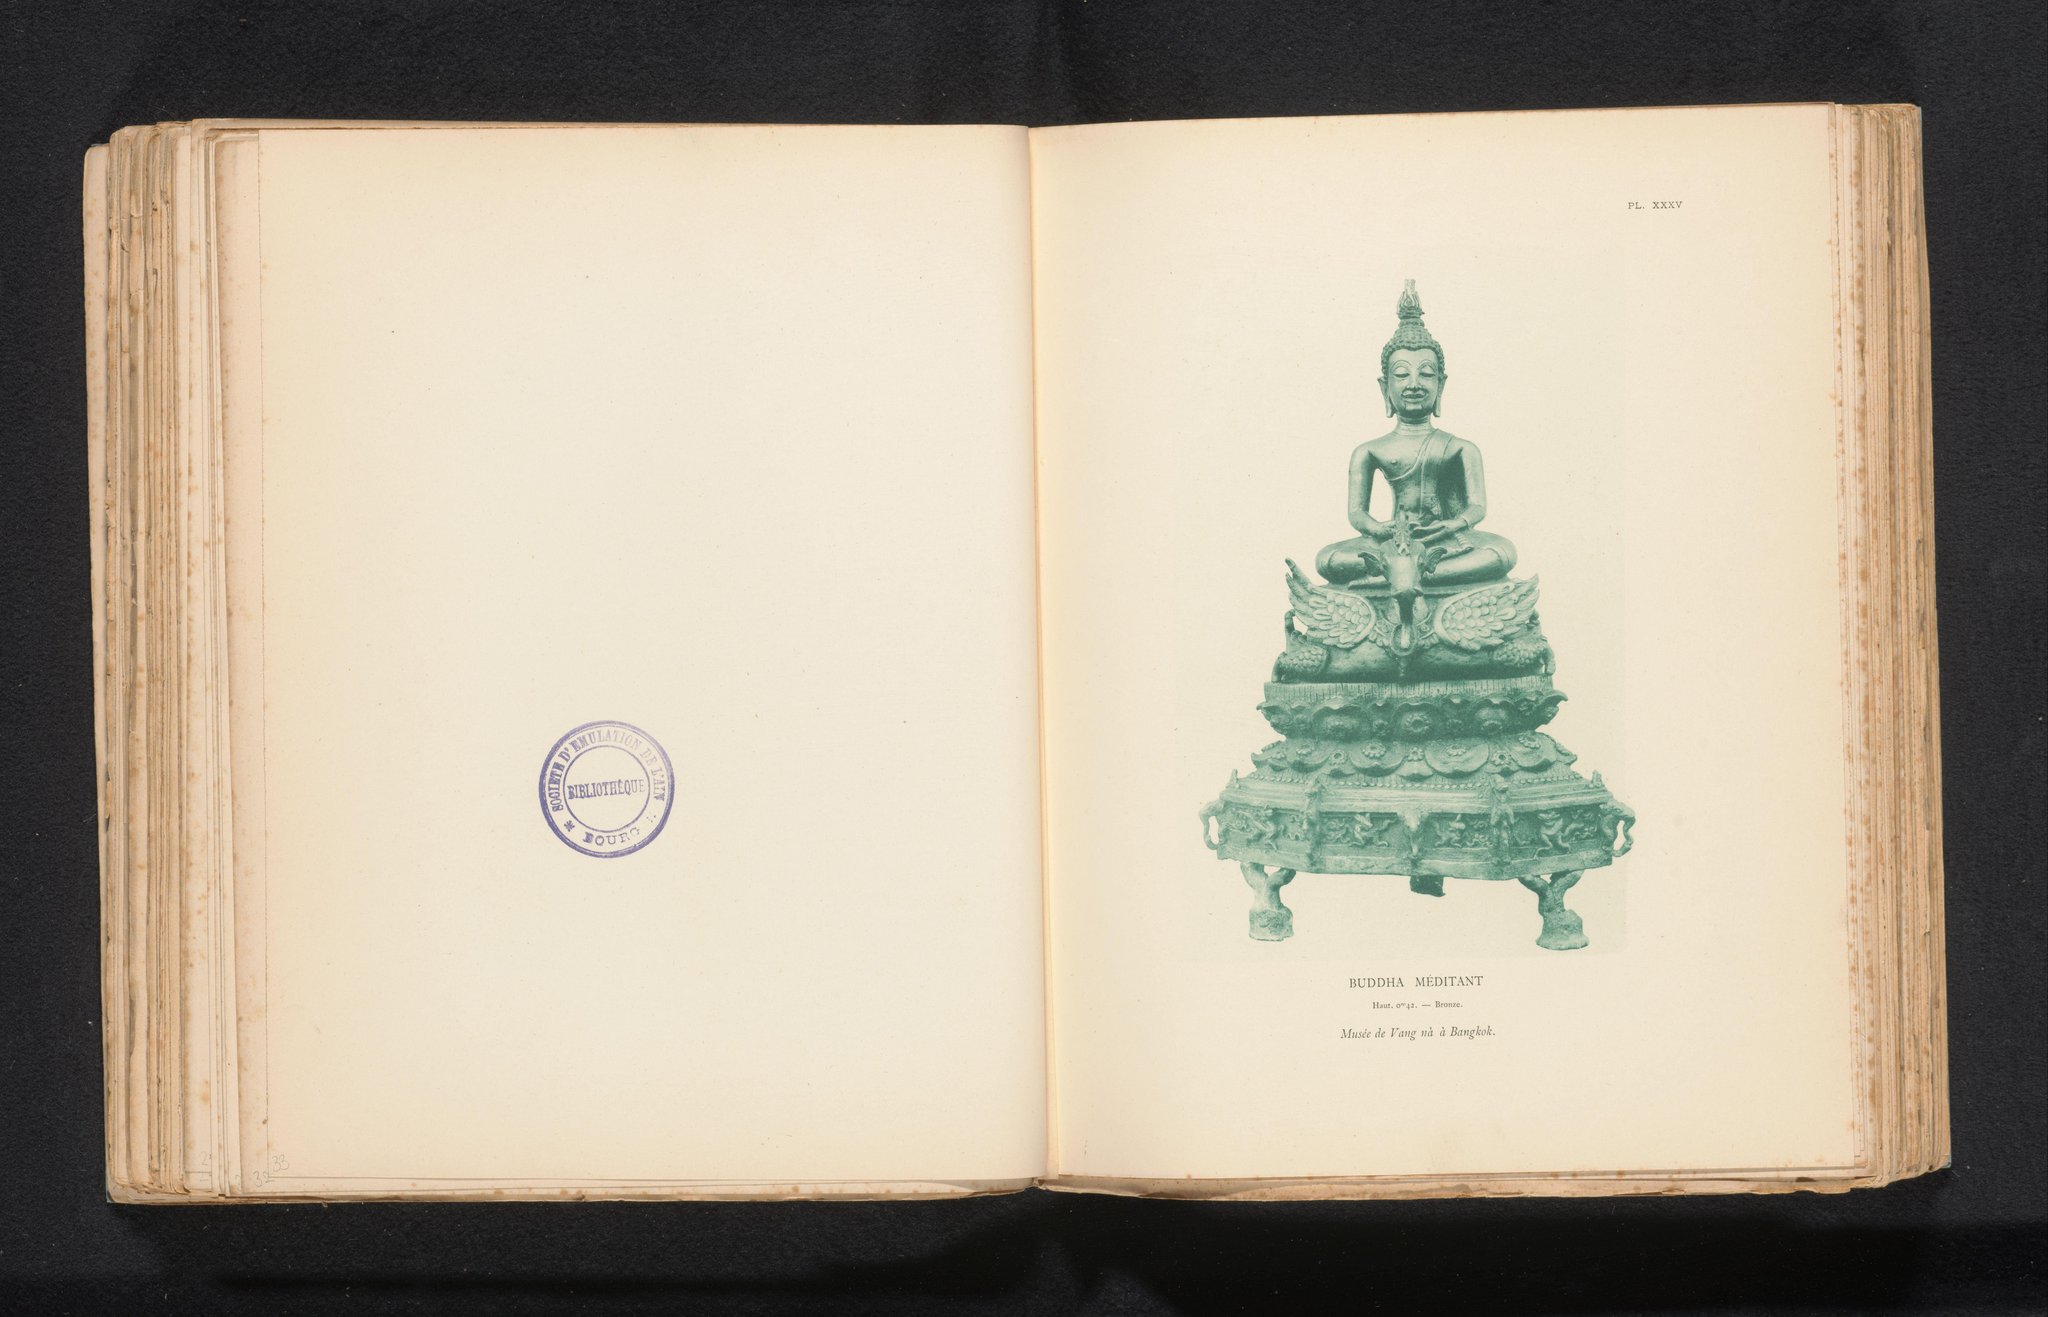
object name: page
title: Sculptuur van Boeddha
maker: Anonymous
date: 1890-1895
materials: paper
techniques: photograph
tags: representations ~ gods, demi-gods, heroes, etc. (hinduism, buddhism, jainism)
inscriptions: collector's mark: ‘Société d'Emulation de l'Ain/ Bourg/ Bibliothèque’, inscription: ‘Pl. XXXV’, inscription: ‘haut. 0m42. - Bronze/ Musée de Vang nà, à Bangkok’